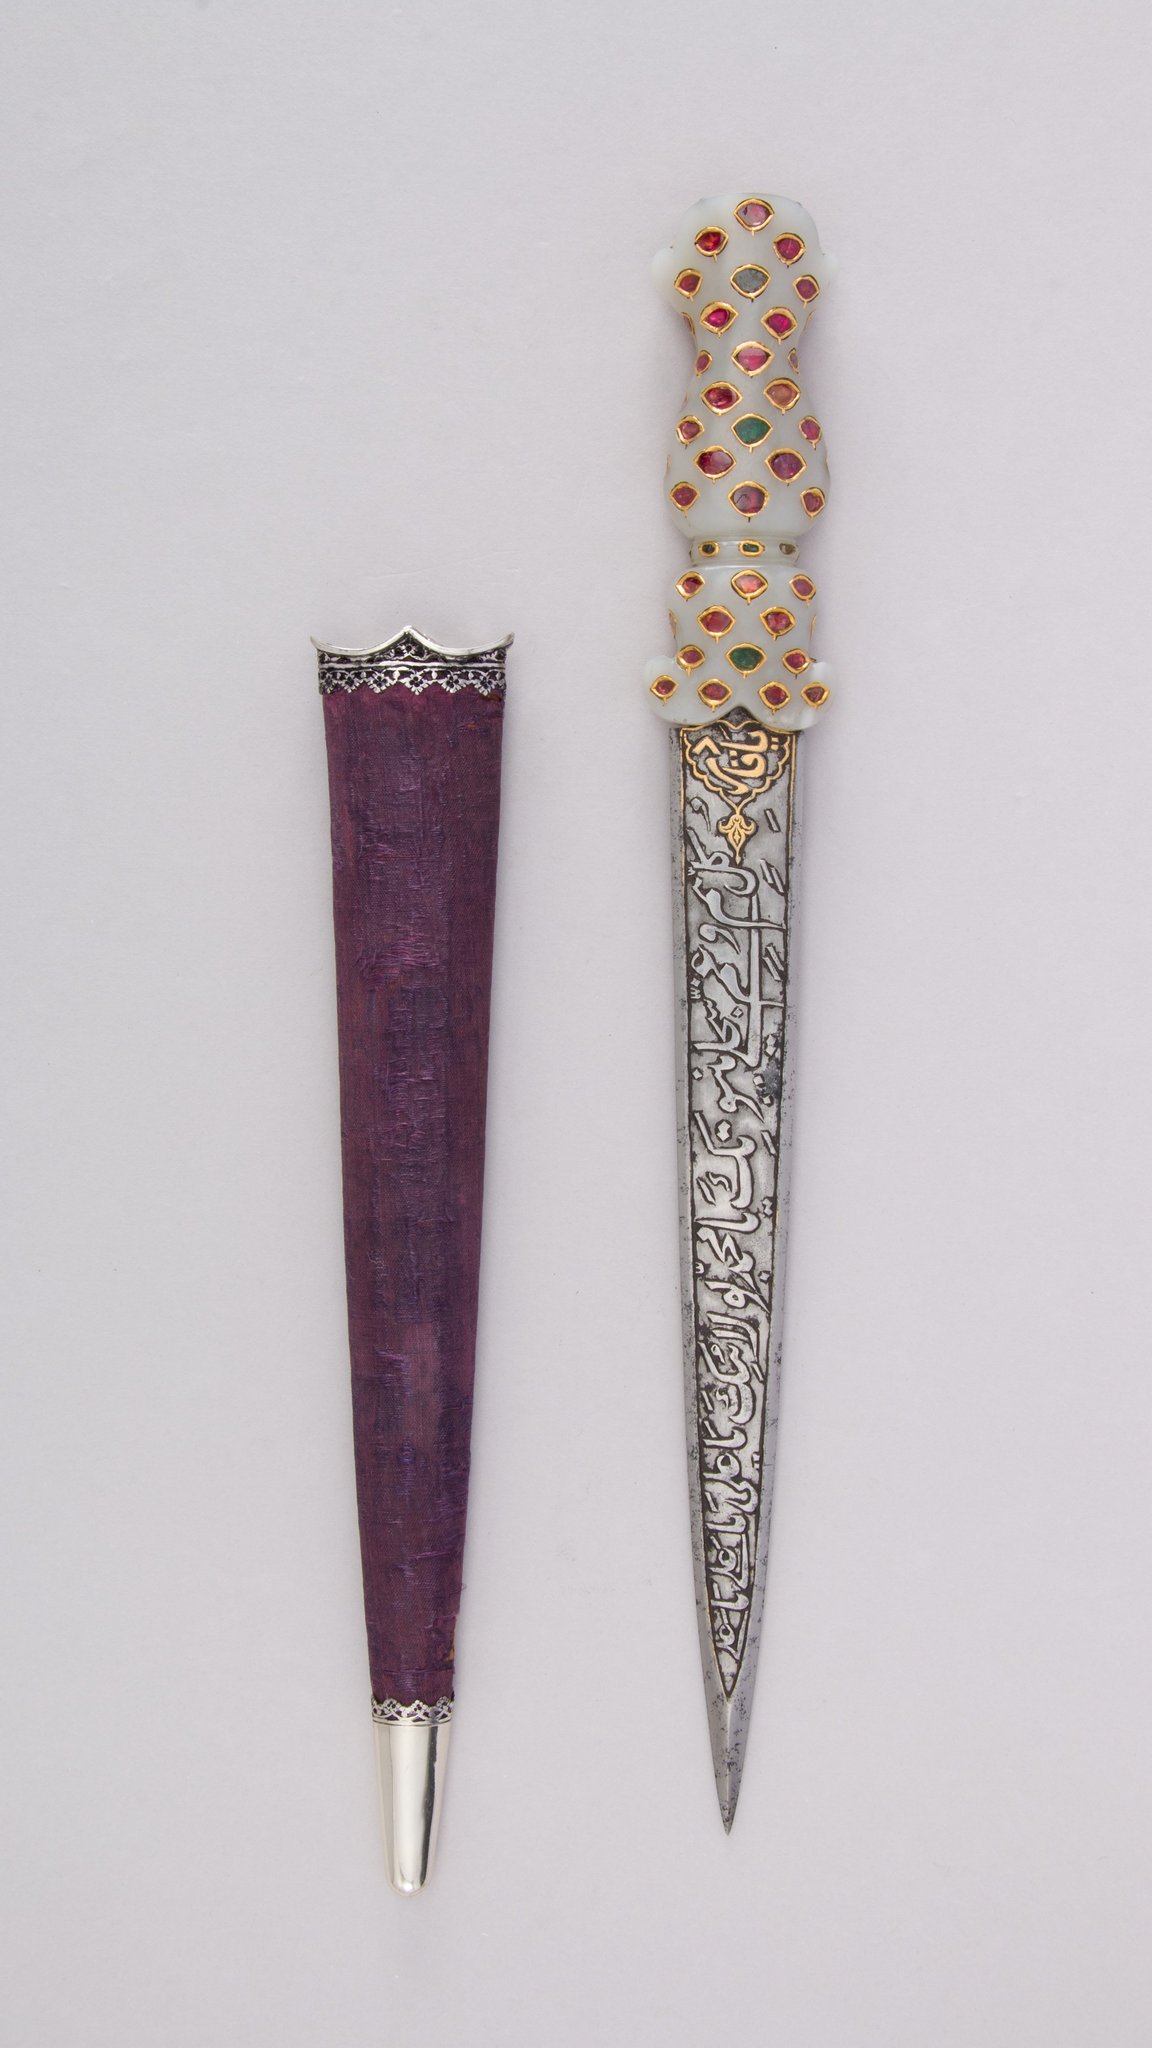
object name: dagger with sheath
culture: indian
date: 1701-1900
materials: gemstone, gold, jade, silver, steel, velvet, wood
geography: india